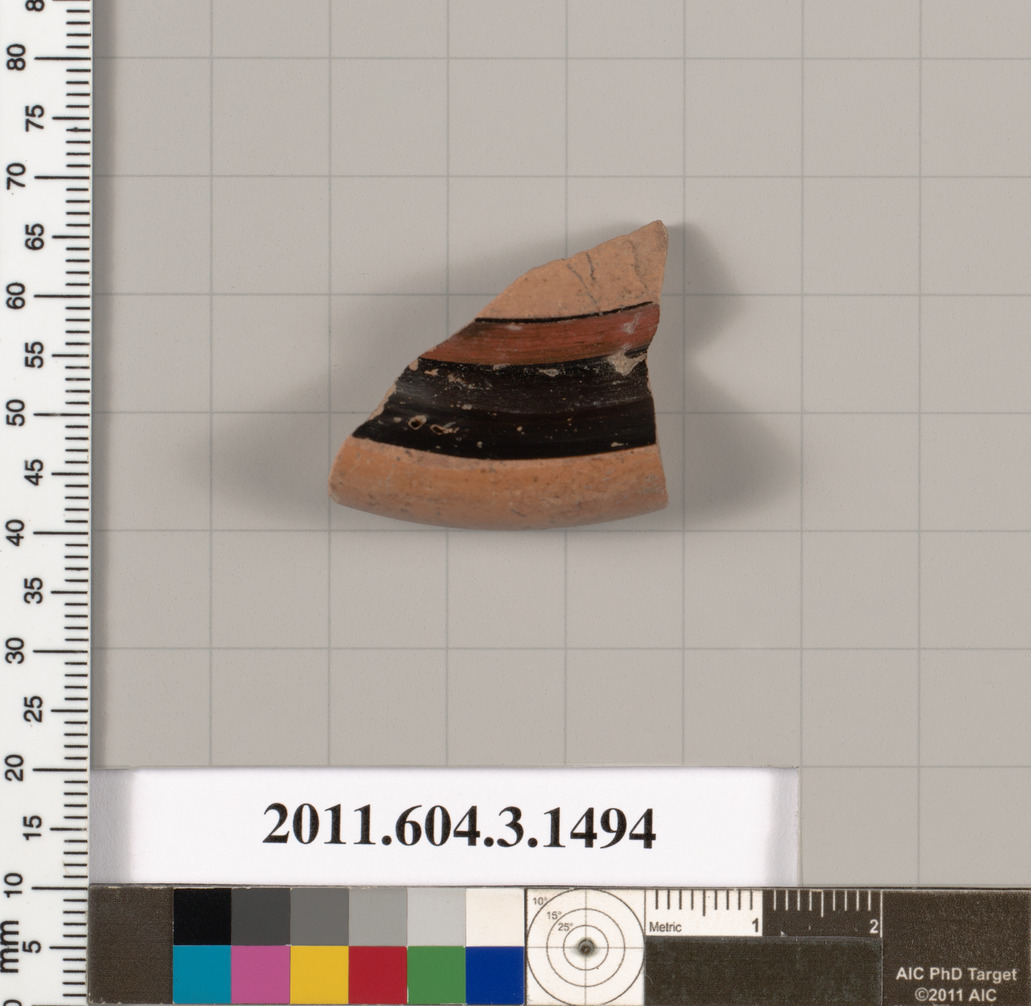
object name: skyphos fragment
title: Terracotta fragment of a skyphos (deep drinking cup)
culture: greek, attic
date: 600-401 BCE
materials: terracotta